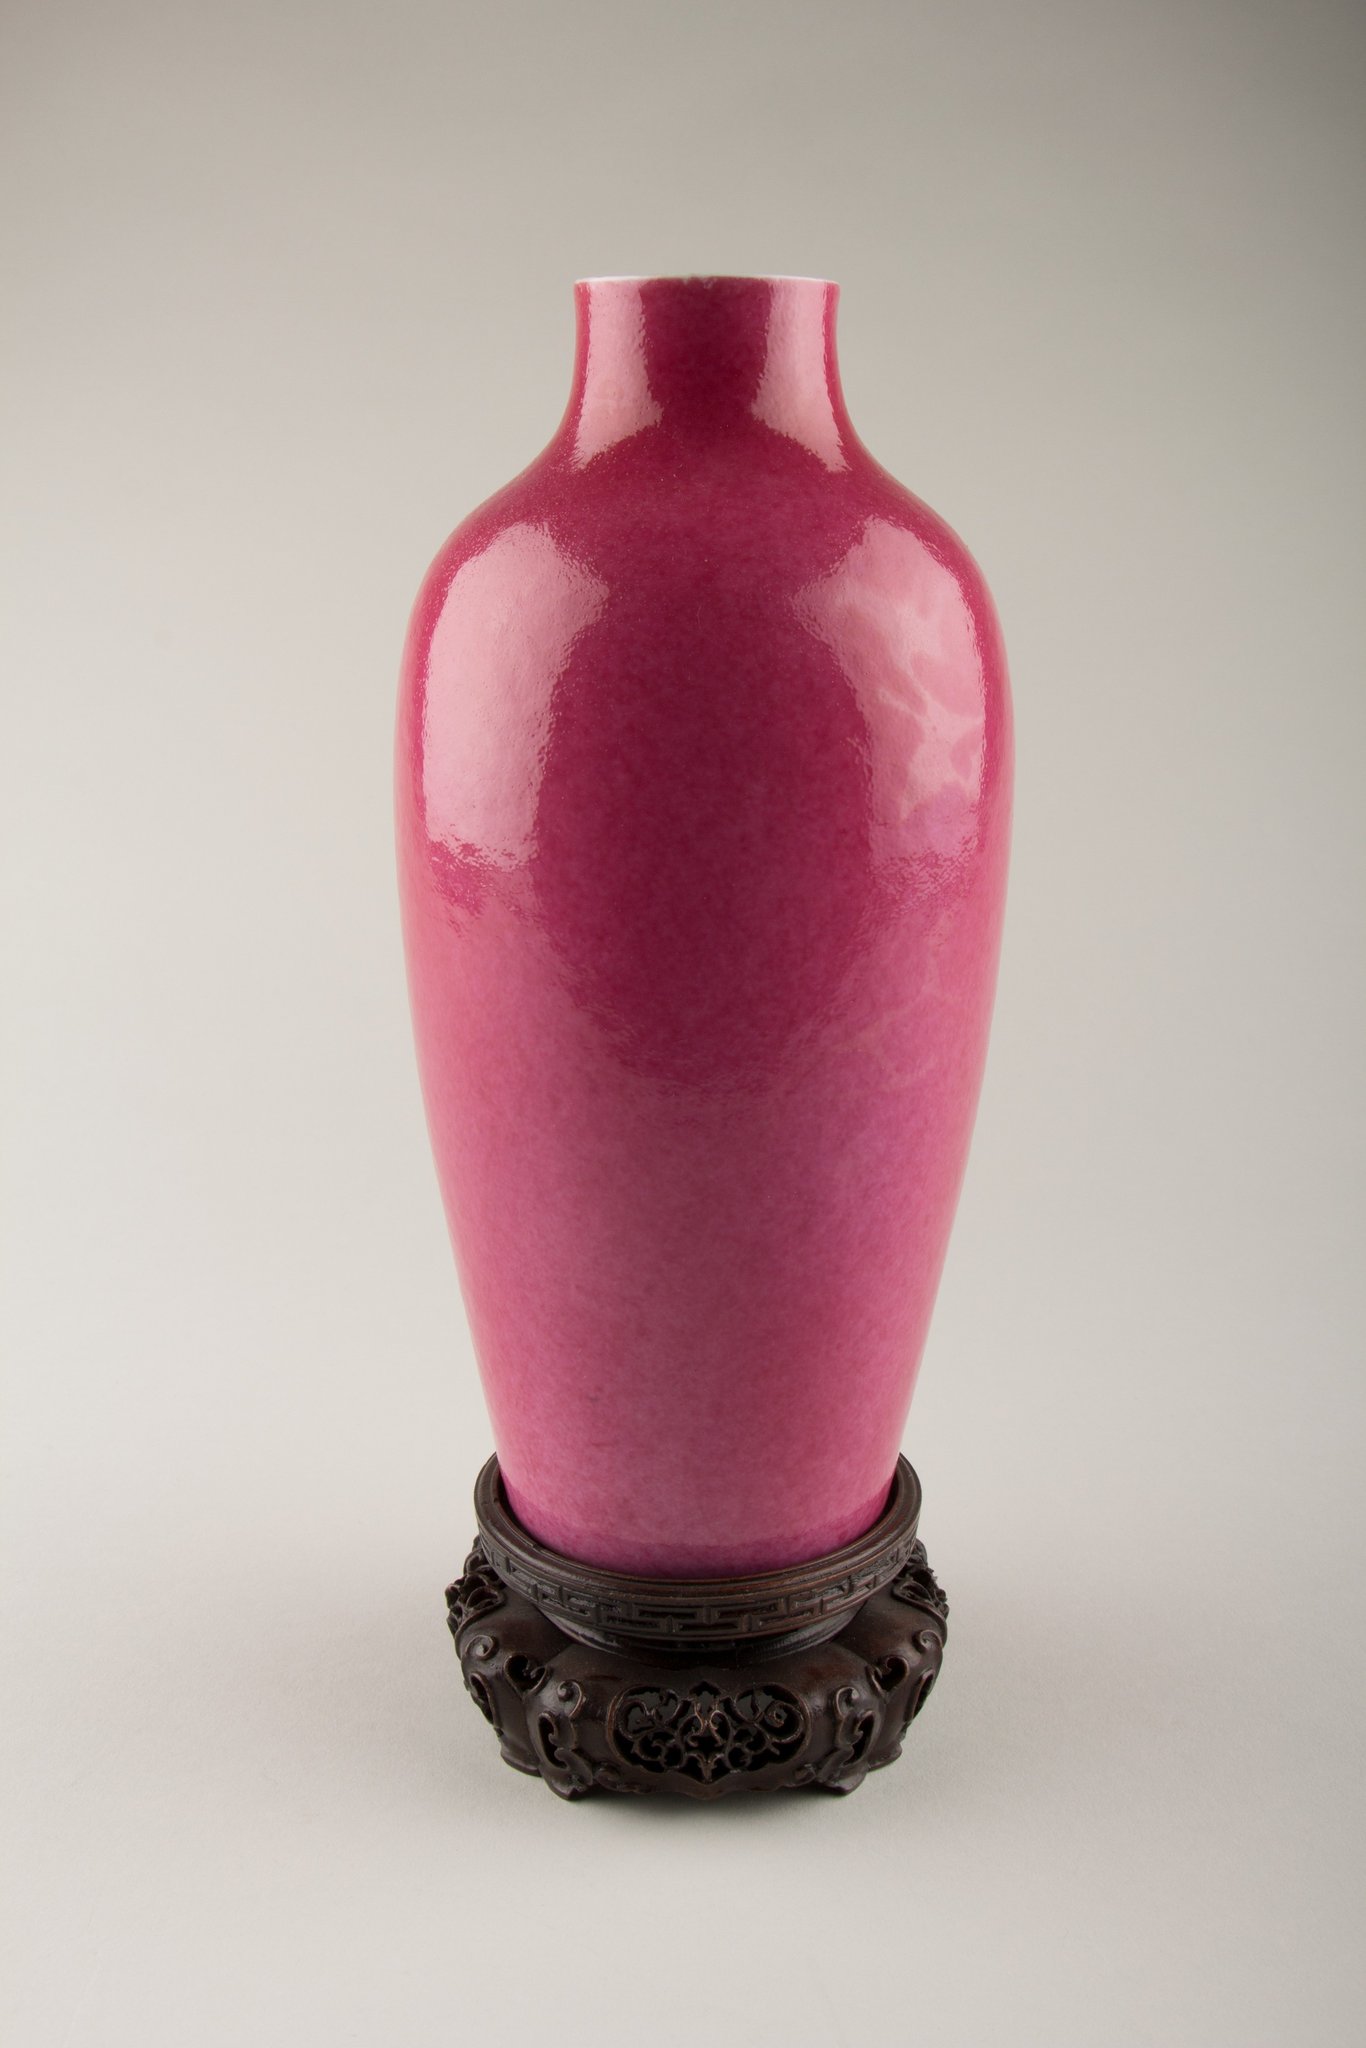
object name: vase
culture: chinese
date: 1736-1795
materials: porcelain